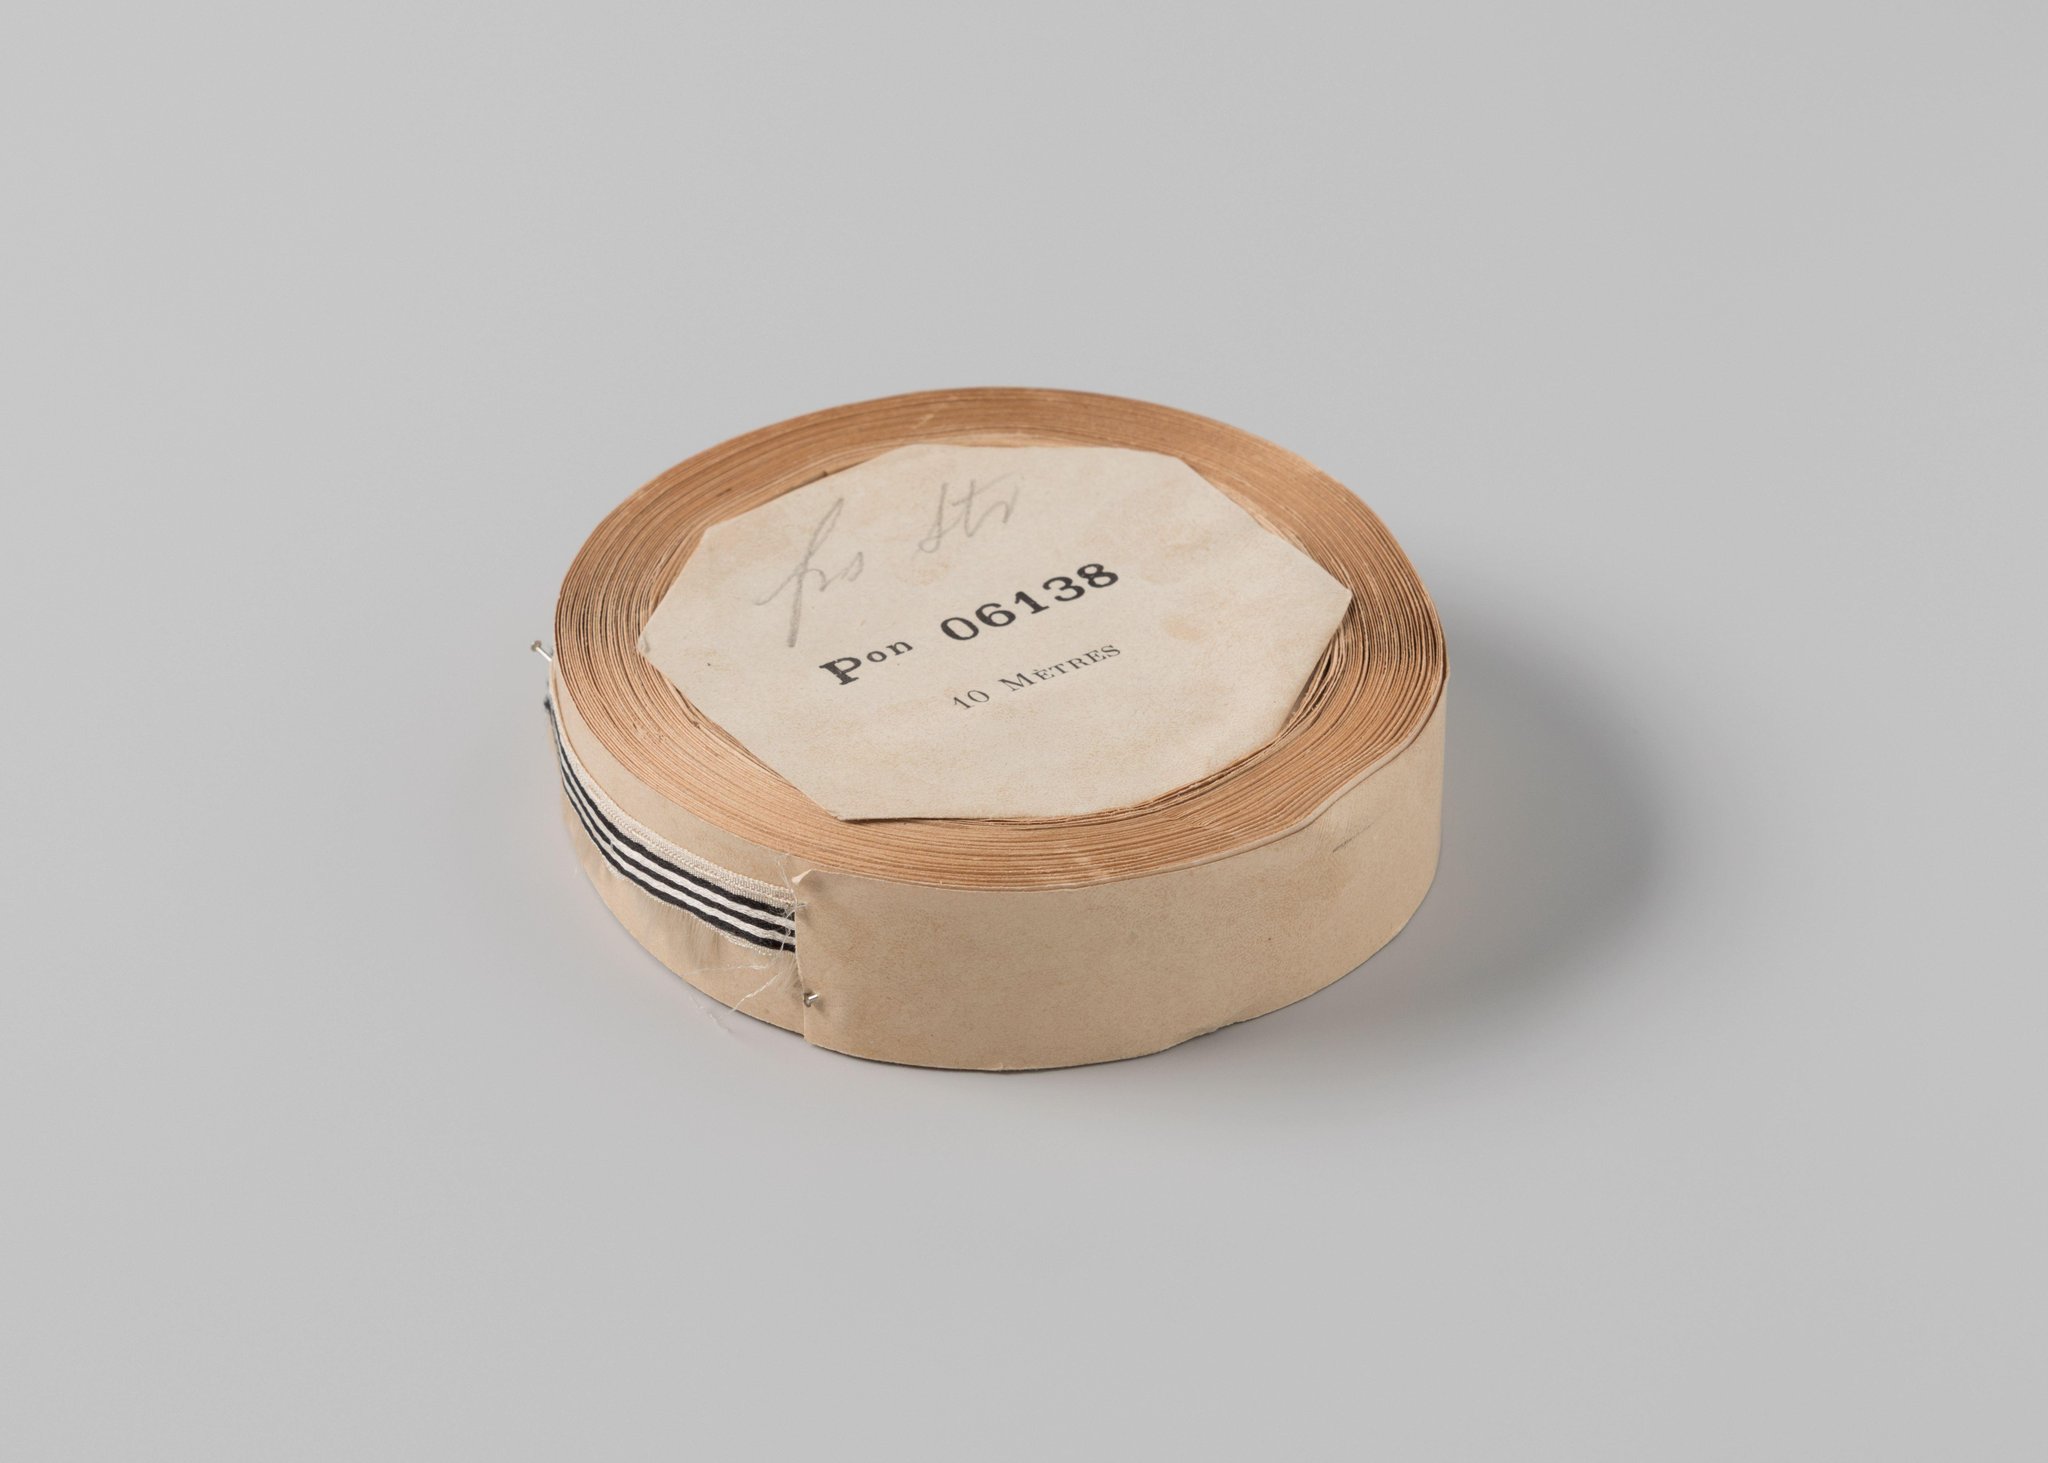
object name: rol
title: Rol met wit lint met één gerafelde zijde en drie zwarte horizontale strepen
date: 1930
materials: cardboard, paper, textile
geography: france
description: Rol met wit lint met één gerafelde zijde en drie zwarte horizontale strepen.